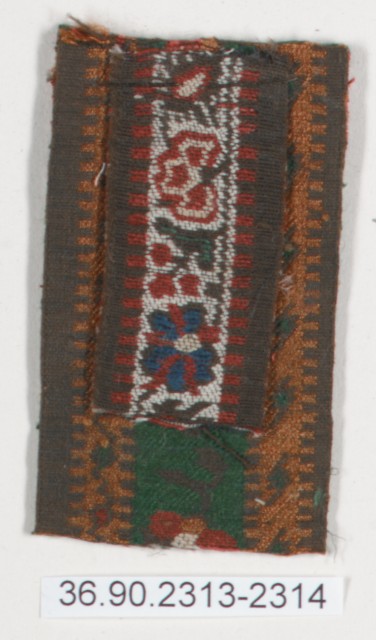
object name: border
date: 1801-1900